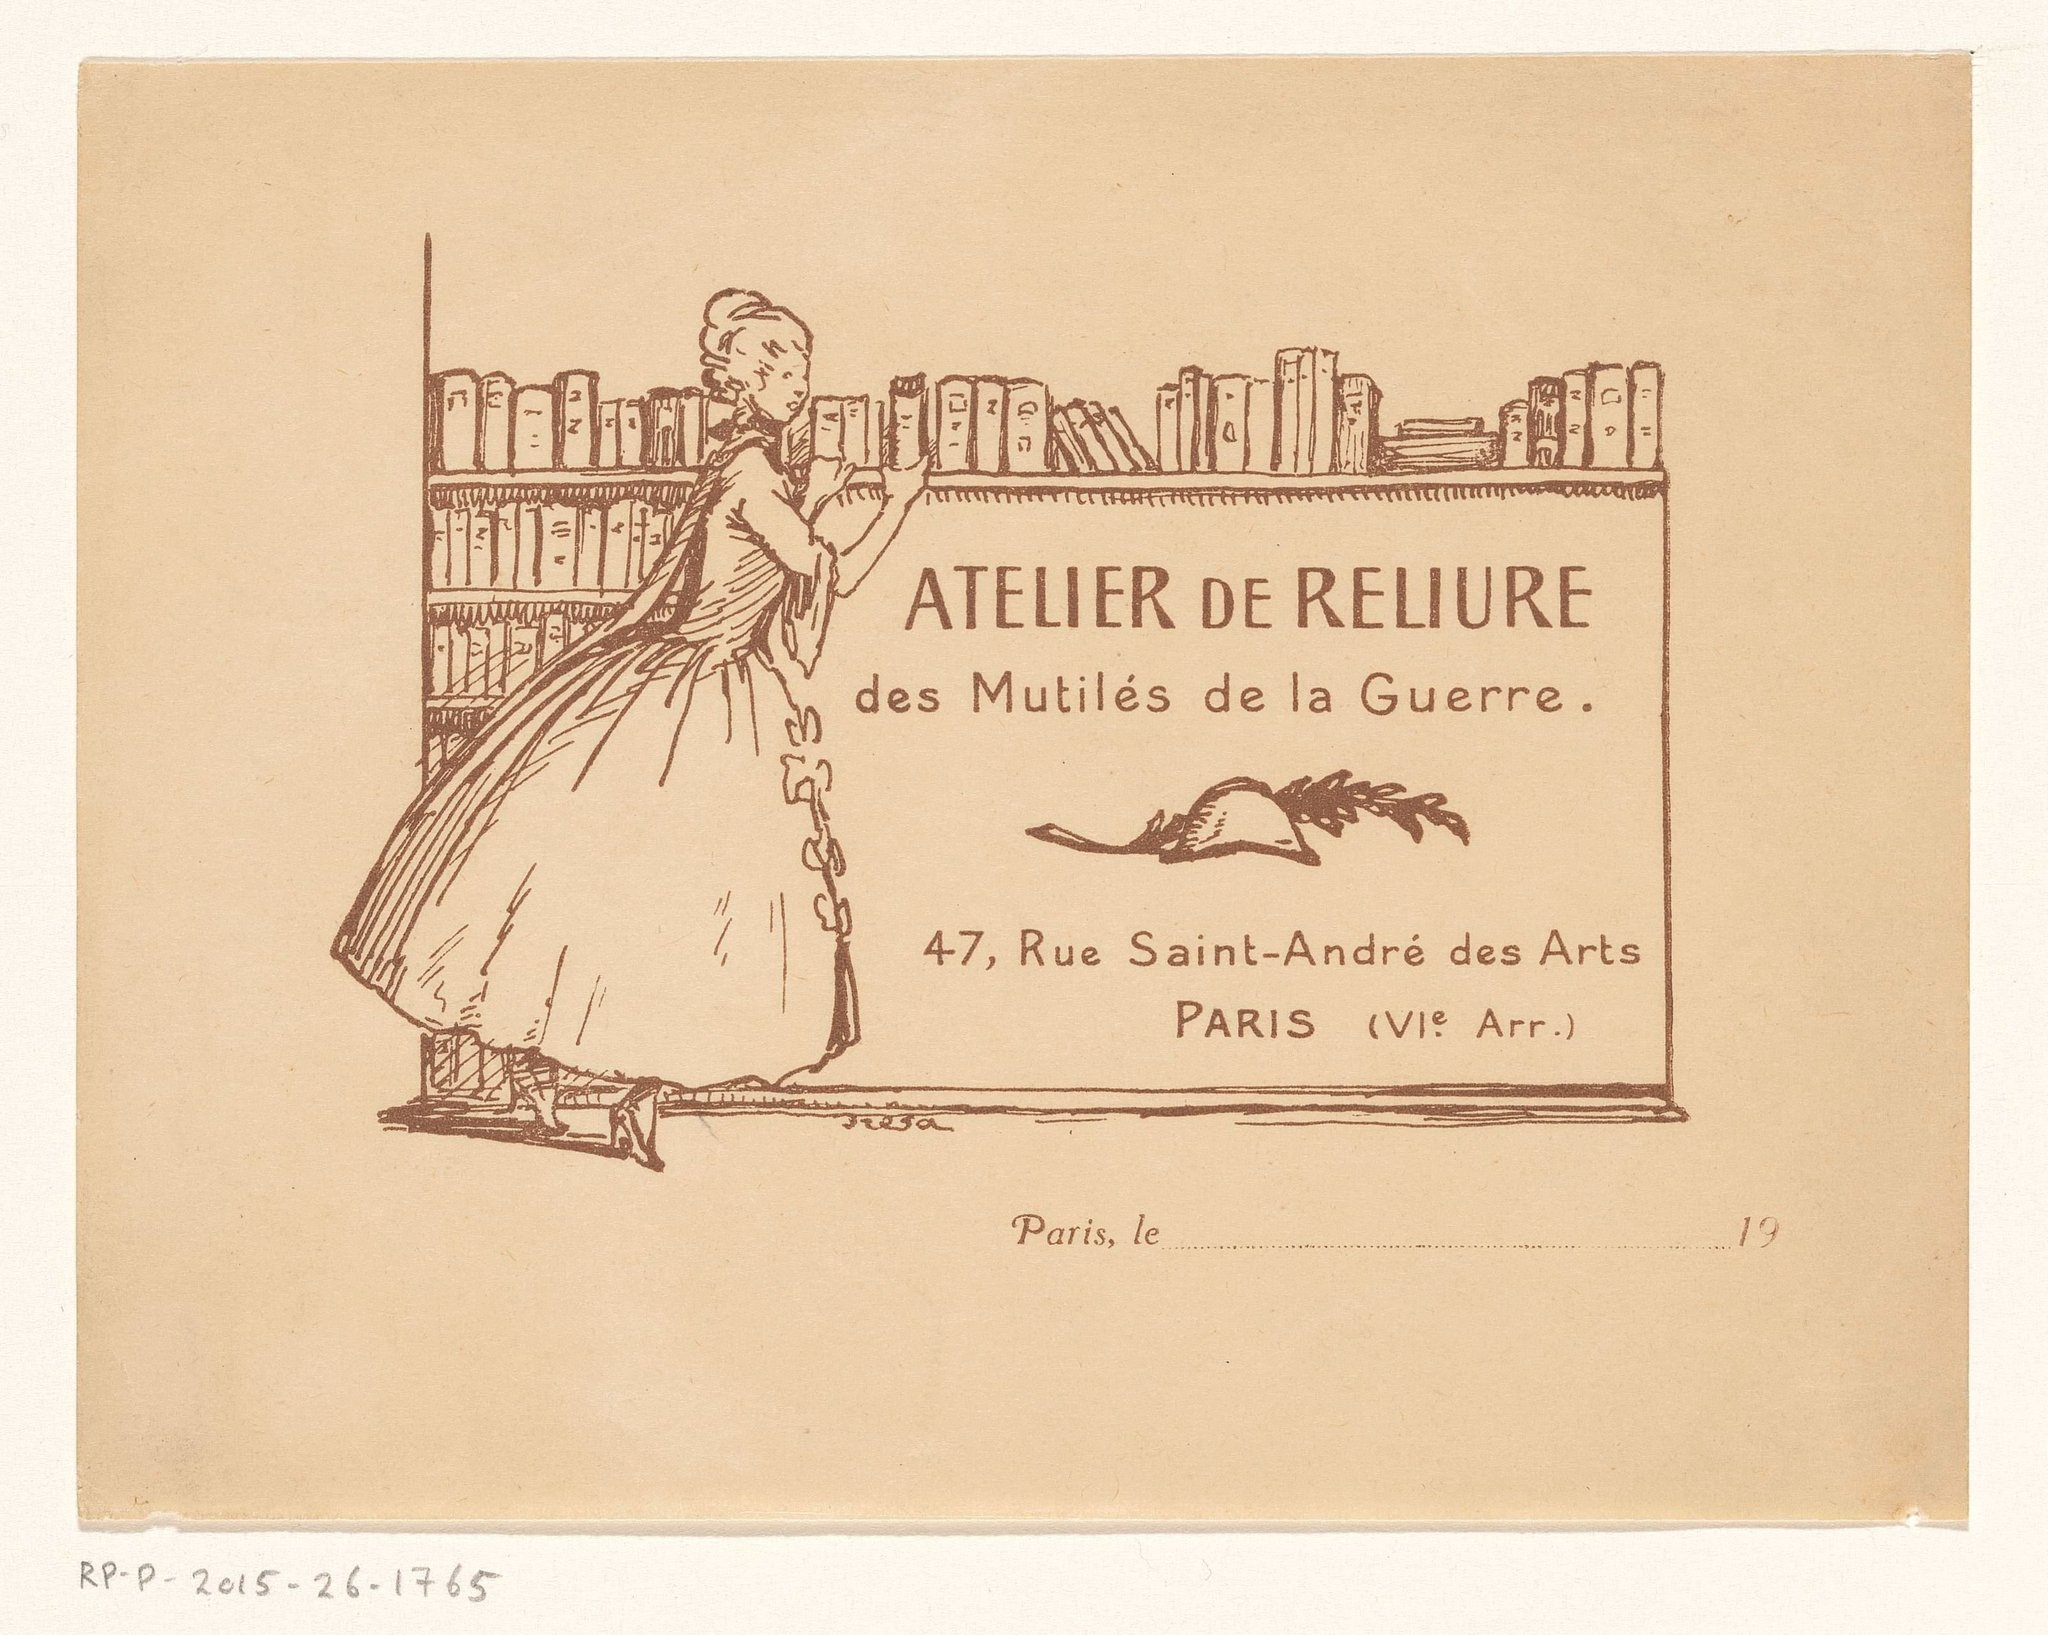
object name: print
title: Visitekaartje van het Atelier de Reliure des Mutilés de la Guerre te Parijs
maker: Anonymous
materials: paper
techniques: lithograph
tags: bookshelves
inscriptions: collector's mark: Lugt 2228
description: Een vrouw pakt een boek van de bovenste plank van een boekenkast. Tussen de tekst een helm met een palmtak.